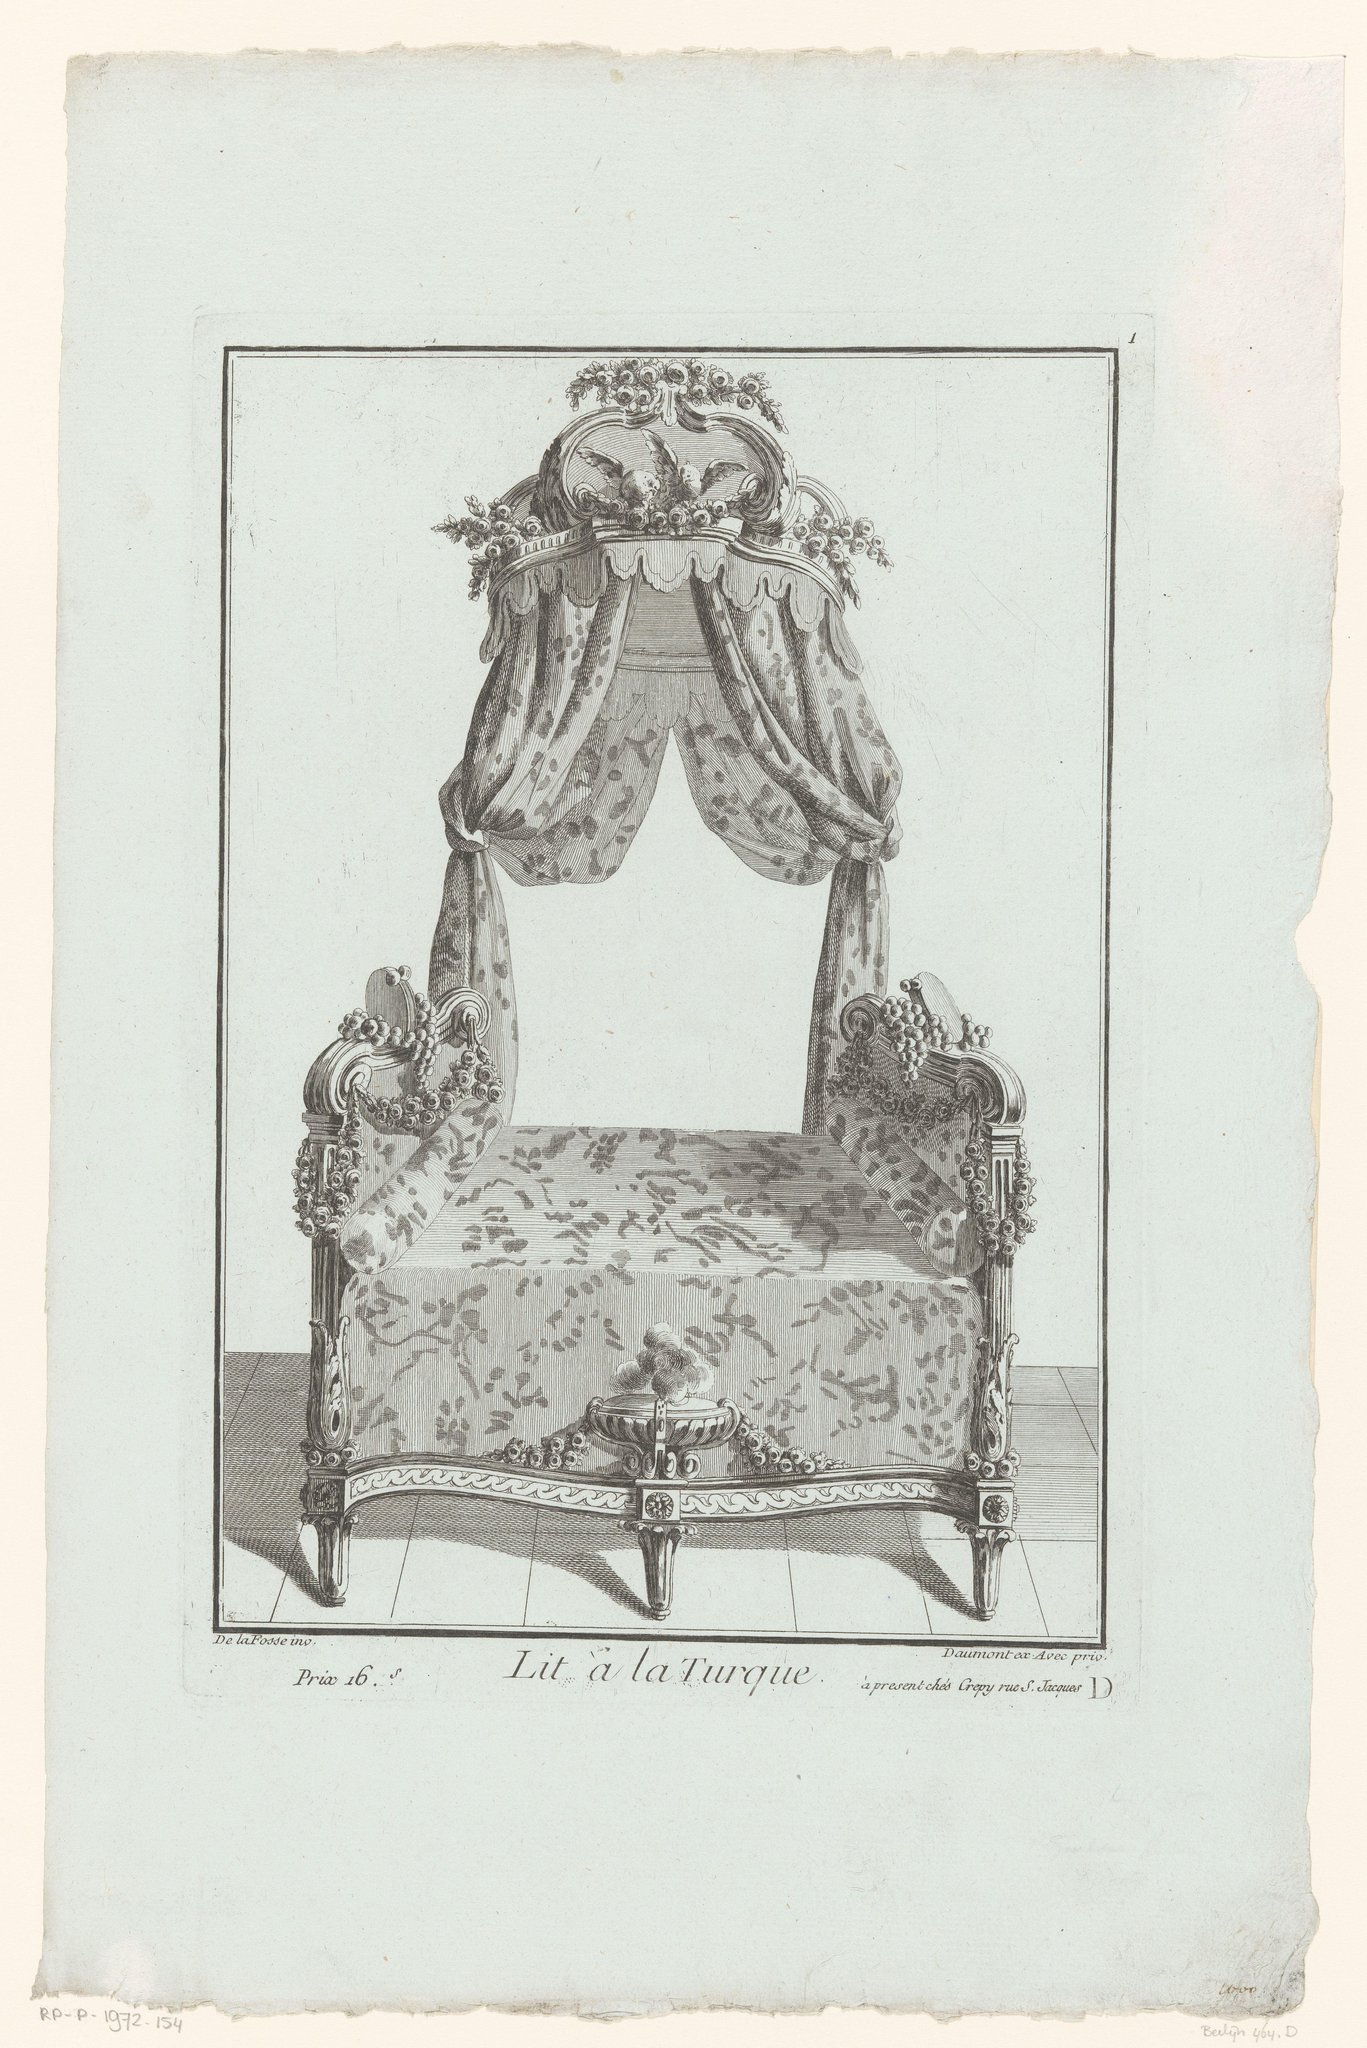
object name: ornament print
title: D Bedden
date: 1753-1775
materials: paper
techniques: engraving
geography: paris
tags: bed with tester, incense-burner ~ scents, perfumes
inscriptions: collector's mark: Lugt 2228, collector's mark: Lugt 2760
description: Een bed met rolkussens, guirlandes, een rookvat en een baldakijn met bloemen en twee duiven.